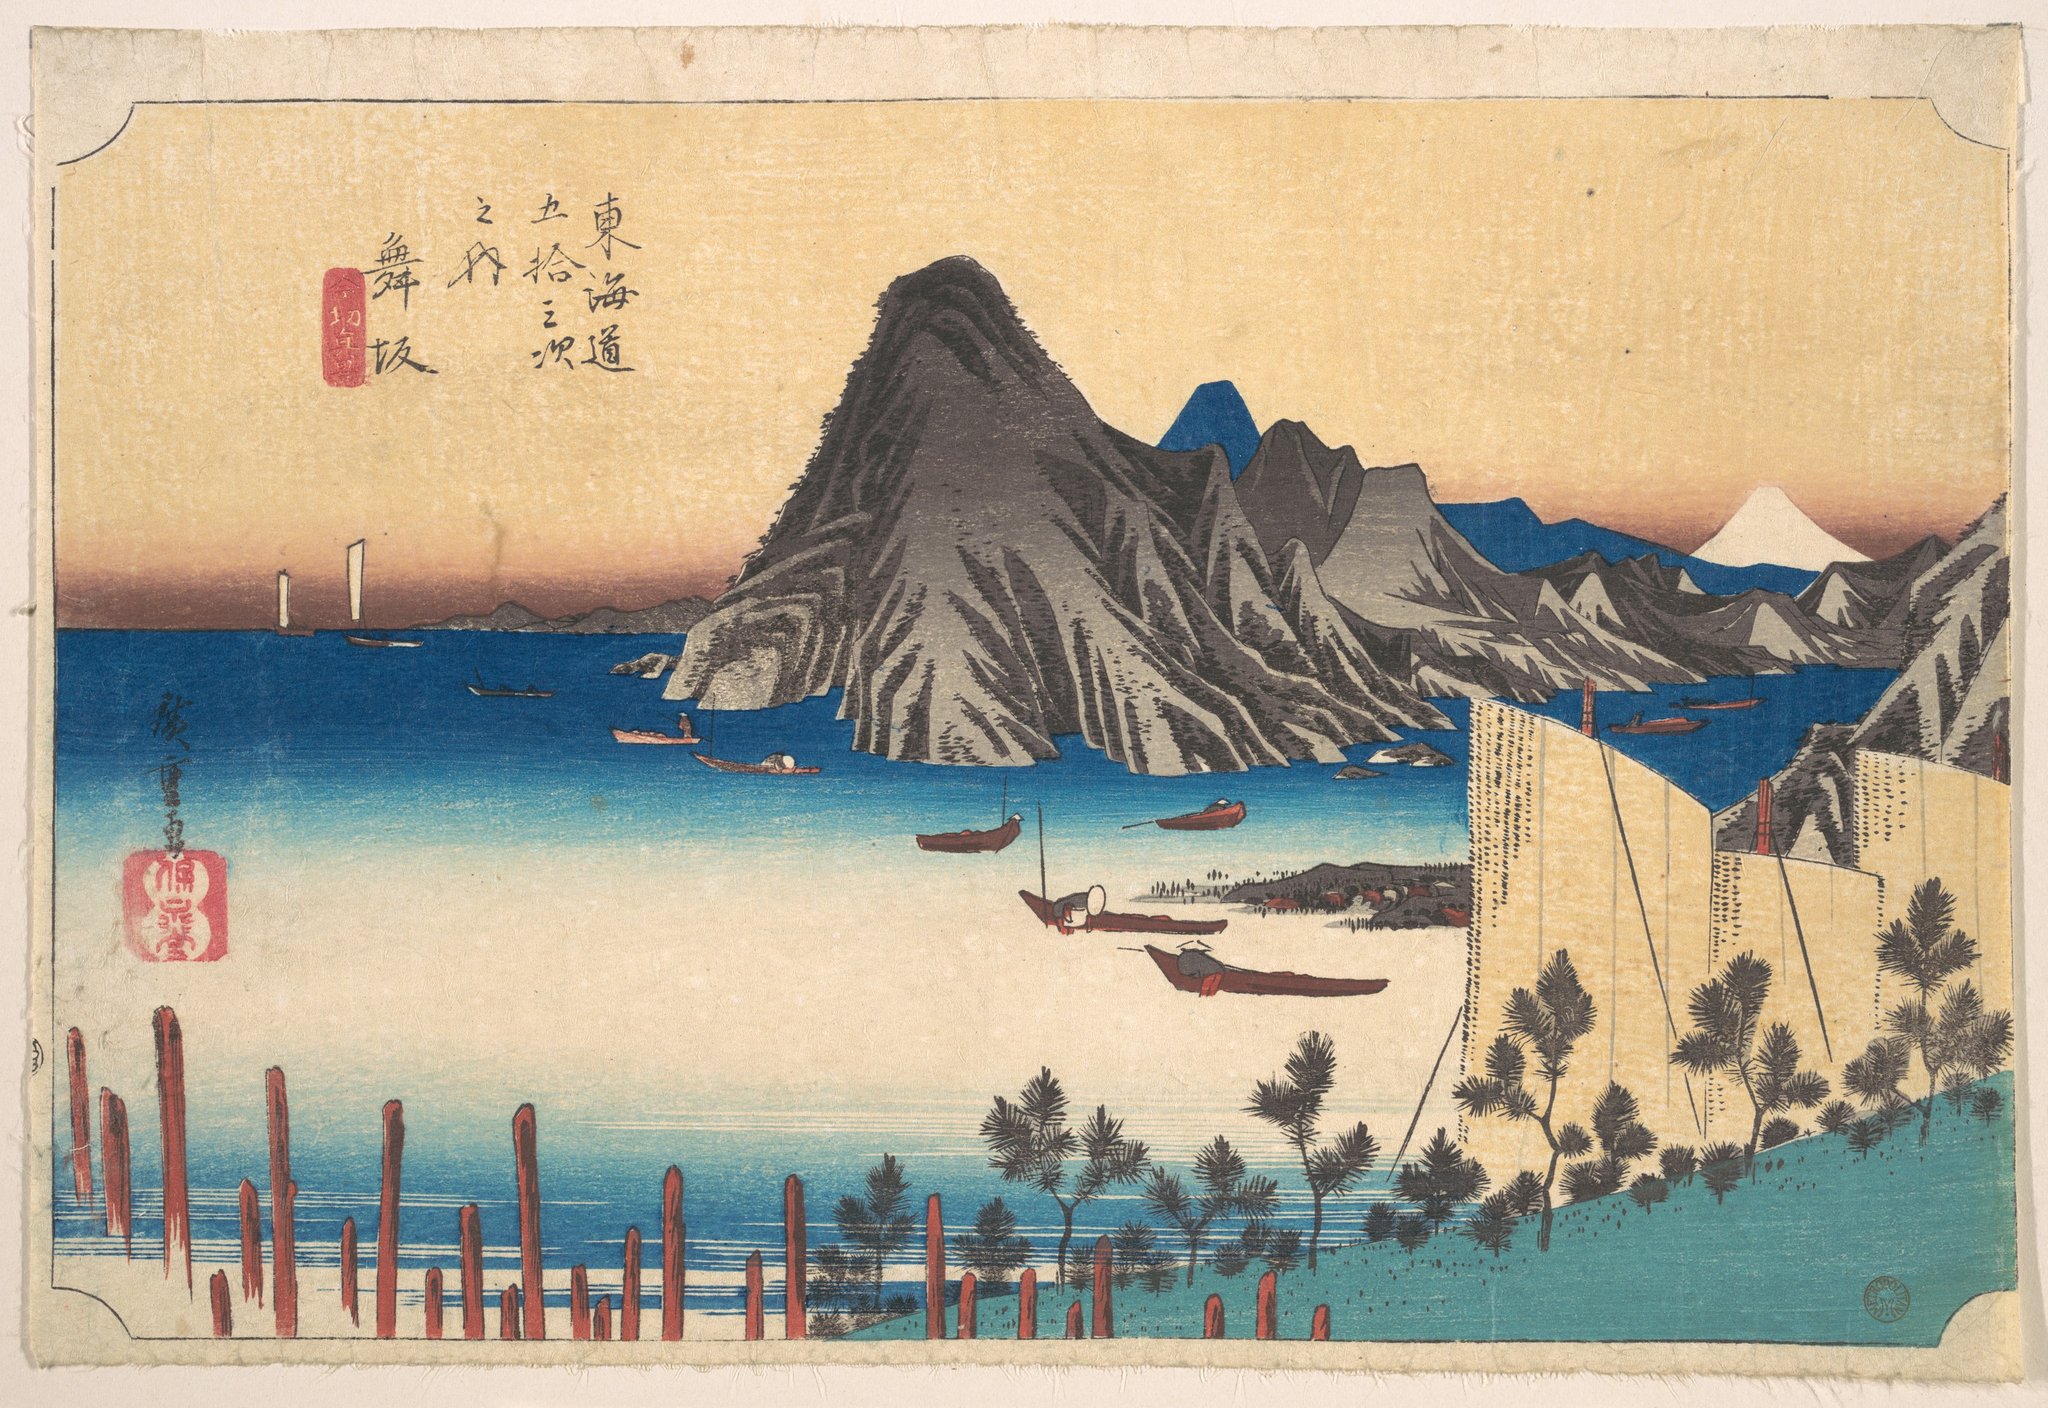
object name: print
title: View of Imaki Point from Maizaka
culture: japanese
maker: utagawa hiroshige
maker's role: artist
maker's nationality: japanese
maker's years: 1797-1858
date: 1834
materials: ink, paper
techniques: woodblock print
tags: mountains,landscapes,boats